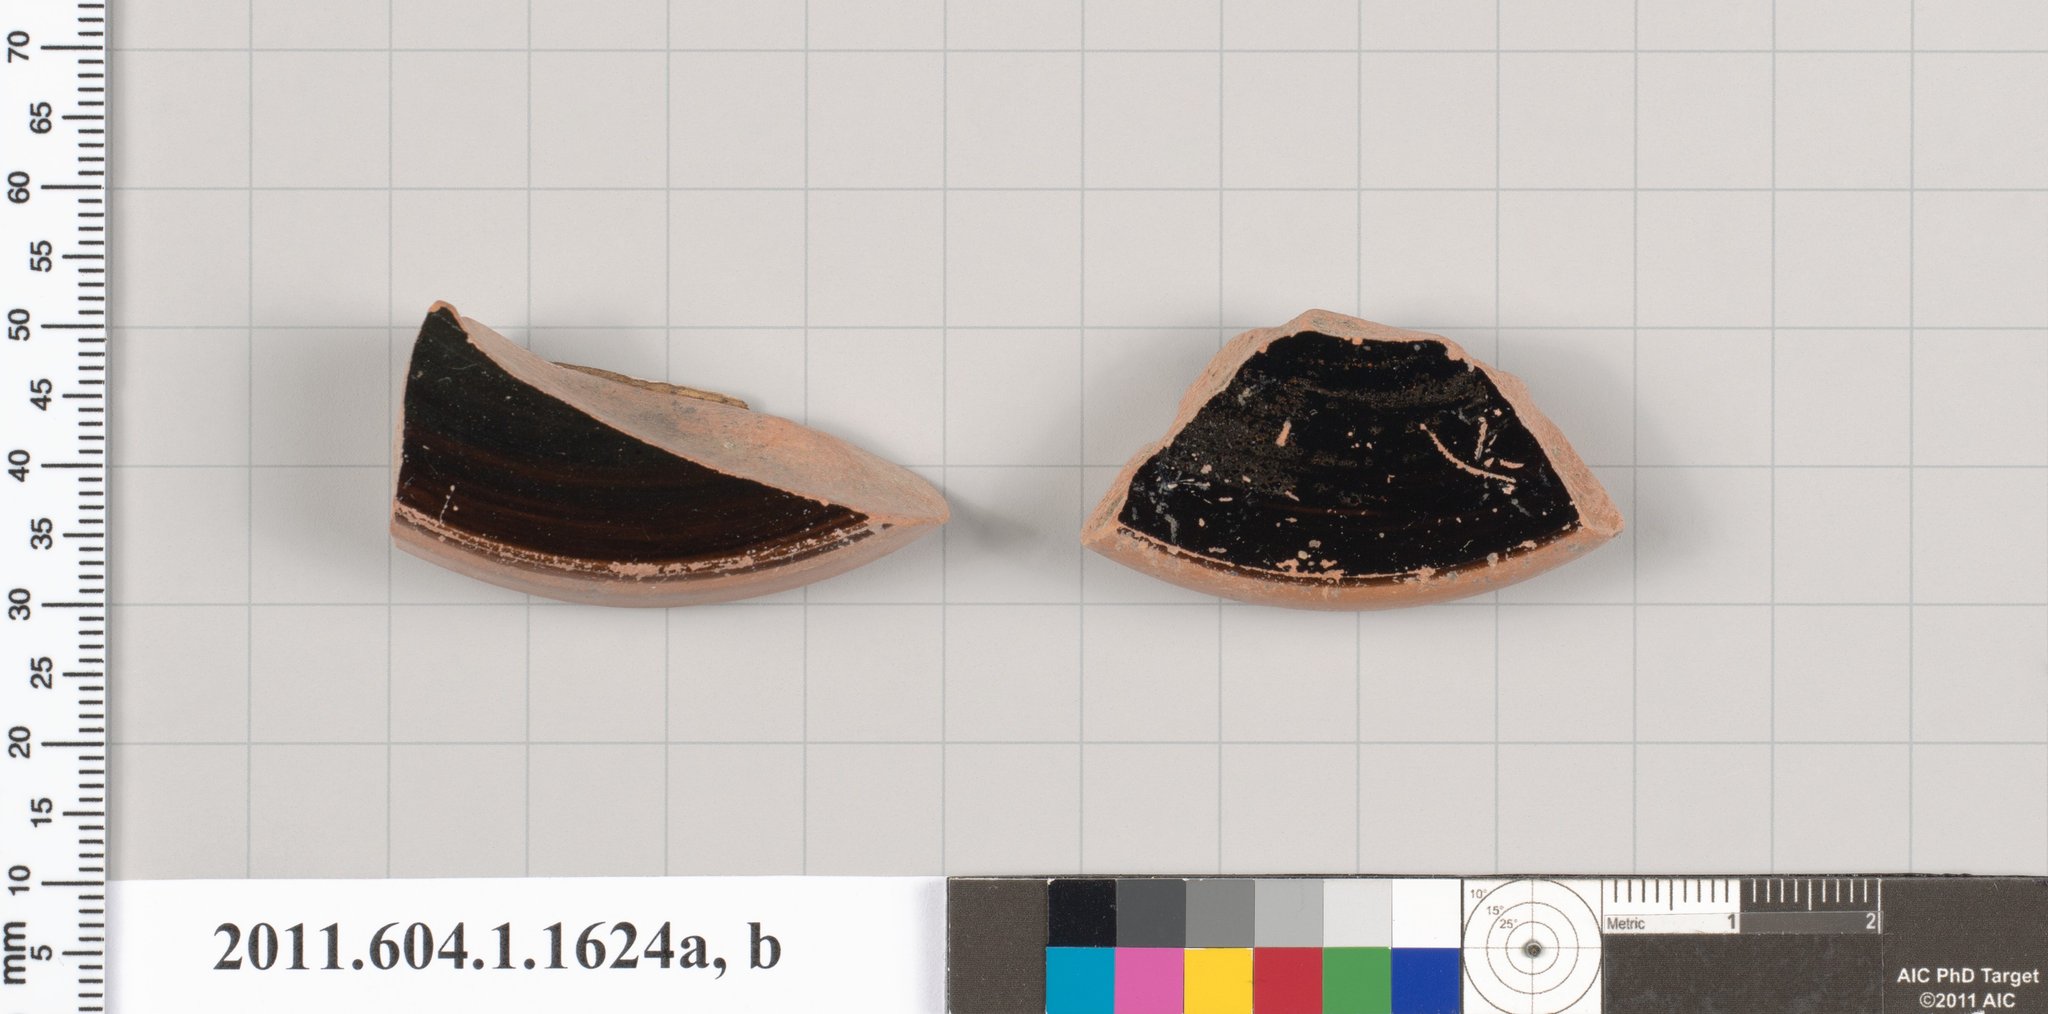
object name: kylix fragment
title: Terracotta fragments of kylikes (drinking cups)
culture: greek, attic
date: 500-401 BCE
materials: terracotta